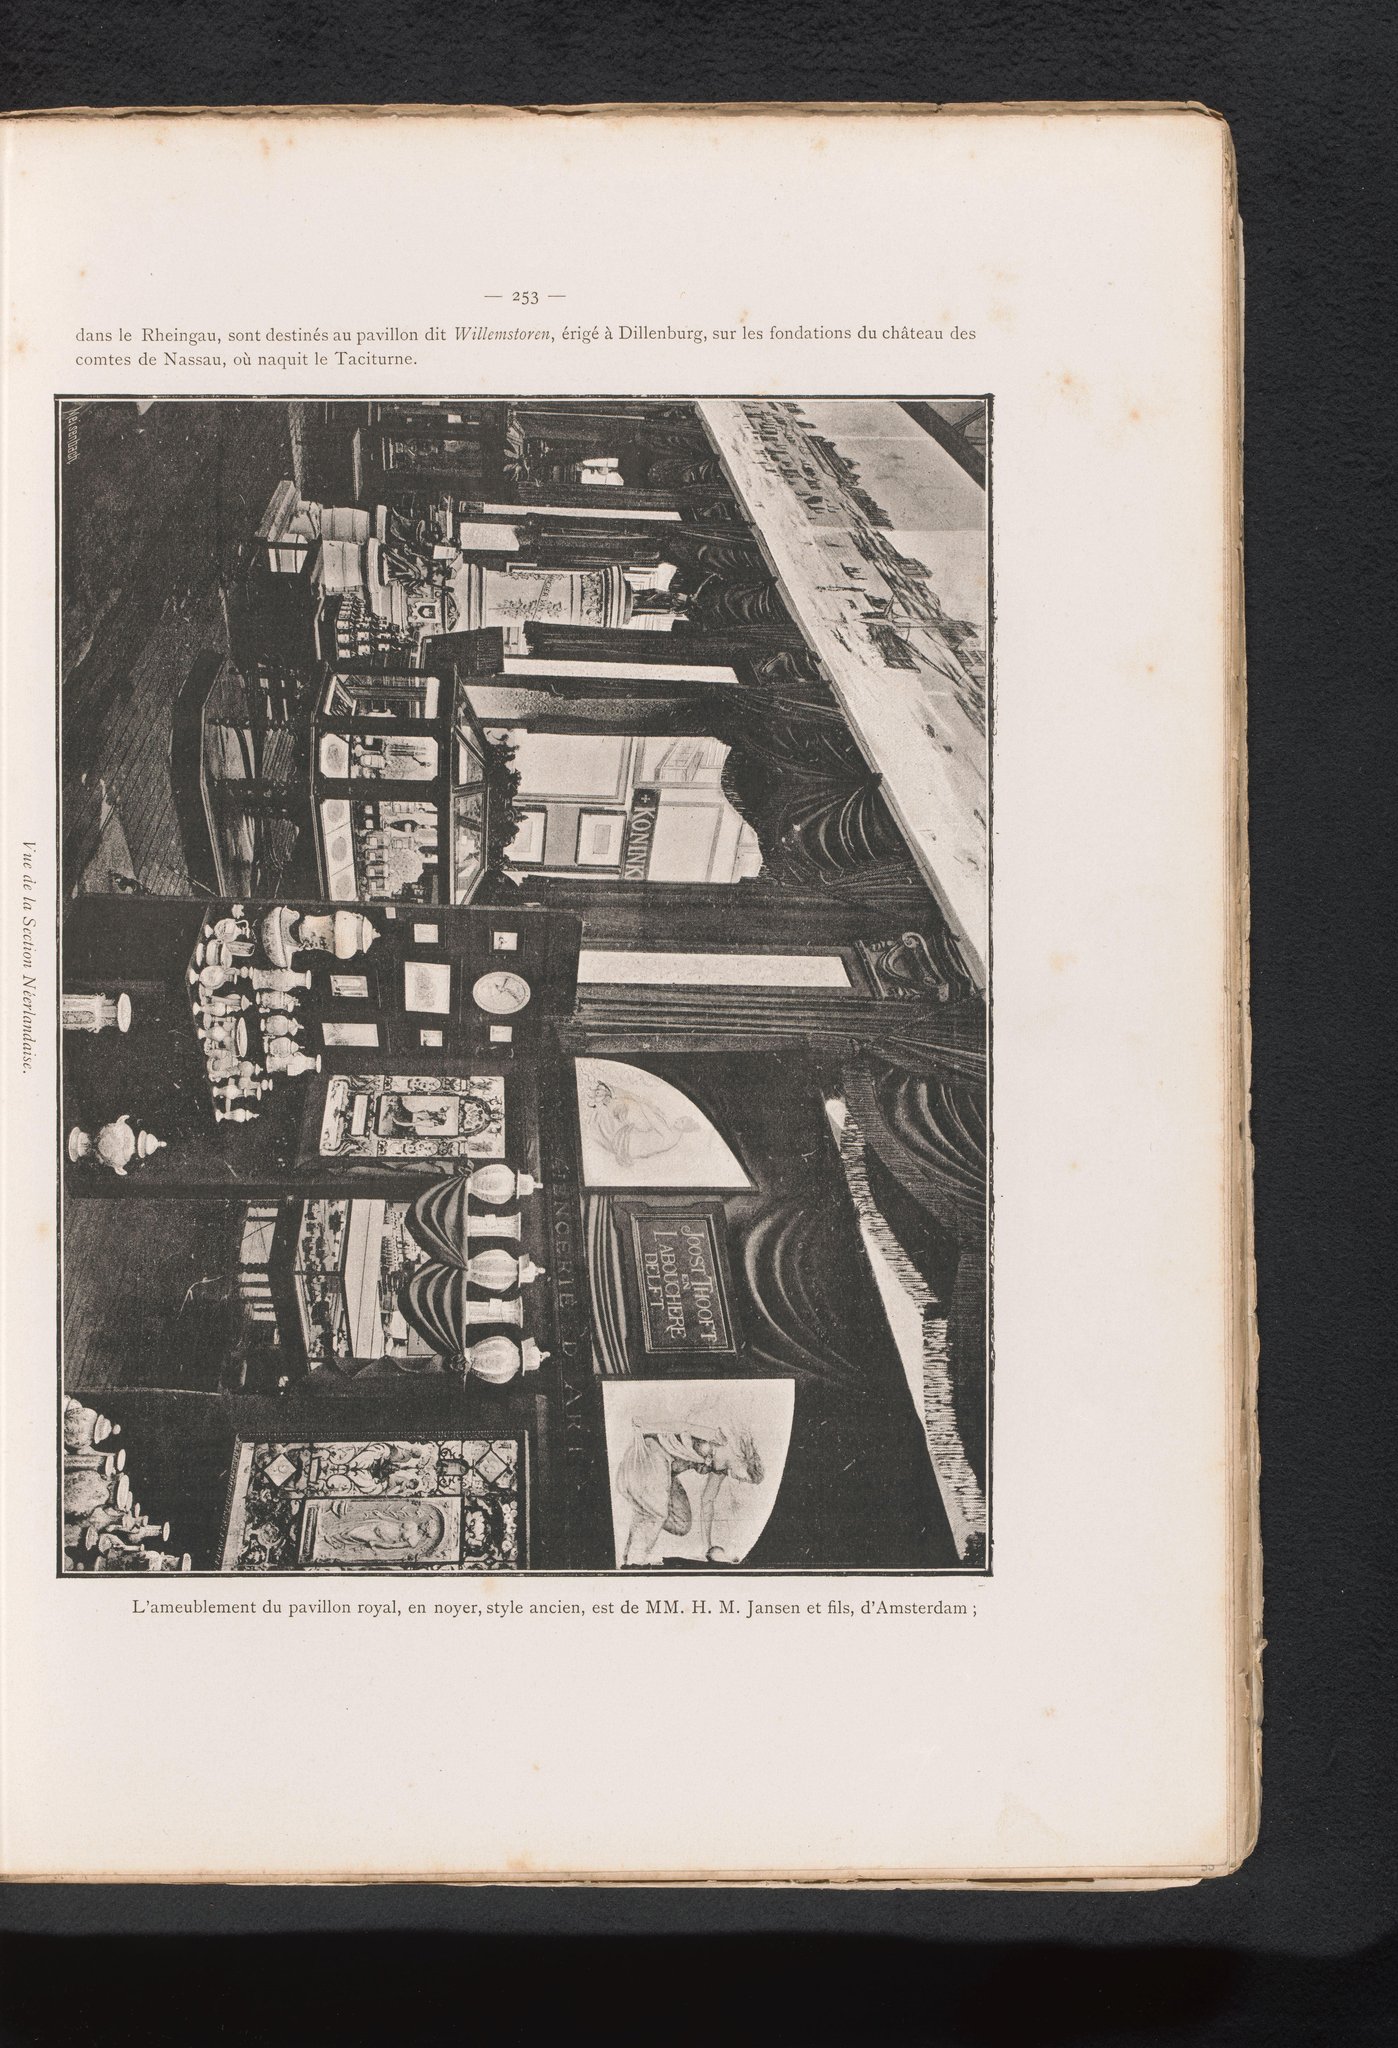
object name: photomechanical print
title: Gezicht op het Nederlandse deel van de Wereldtentoonstelling van 1885 in Antwerpen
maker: Anonymous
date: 1880-1885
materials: paper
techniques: autotype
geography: antwerp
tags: world fair, world exhibition, antwerp